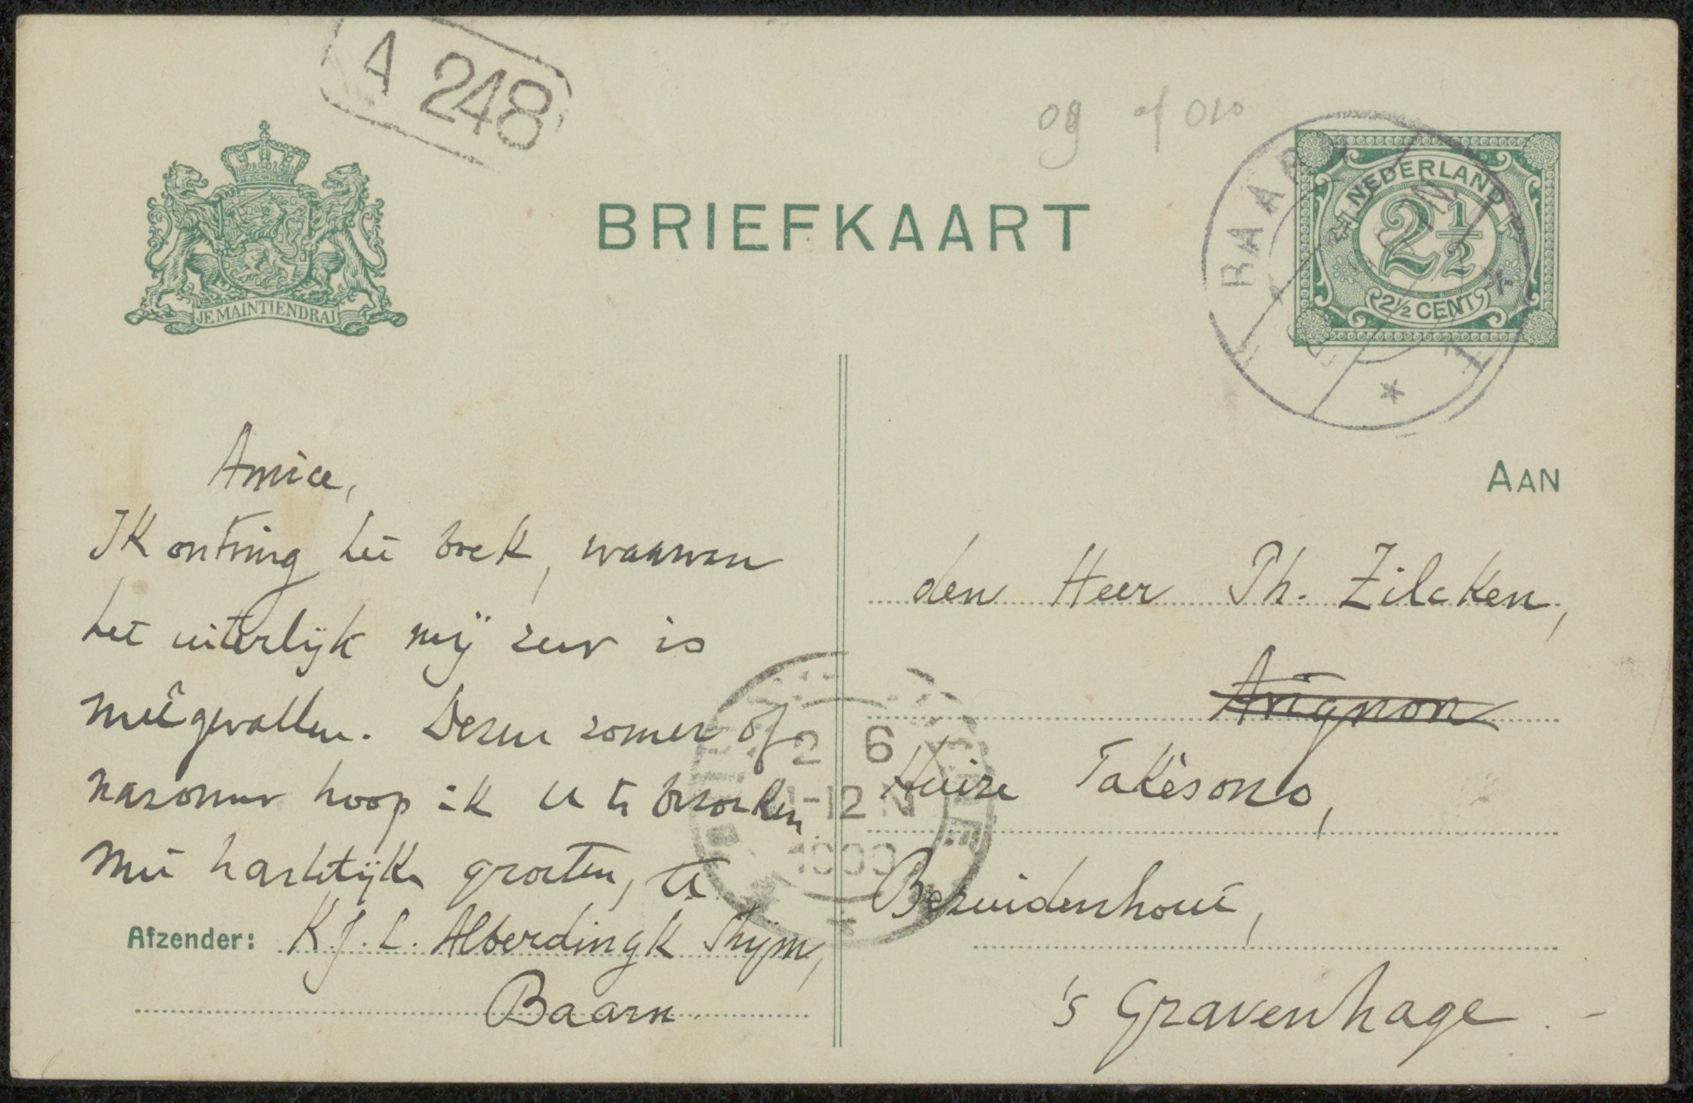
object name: postcard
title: Briefkaart aan Philip Zilcken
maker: karel johan lodewijk alberdingk thijm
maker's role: criticus, prozaschrijver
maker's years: 1864-1952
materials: cardboard, ink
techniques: pen, writing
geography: baarn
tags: the hague, painter, draughtsman, philip zilcken, printed matter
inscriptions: collector's mark: ‘RPK’